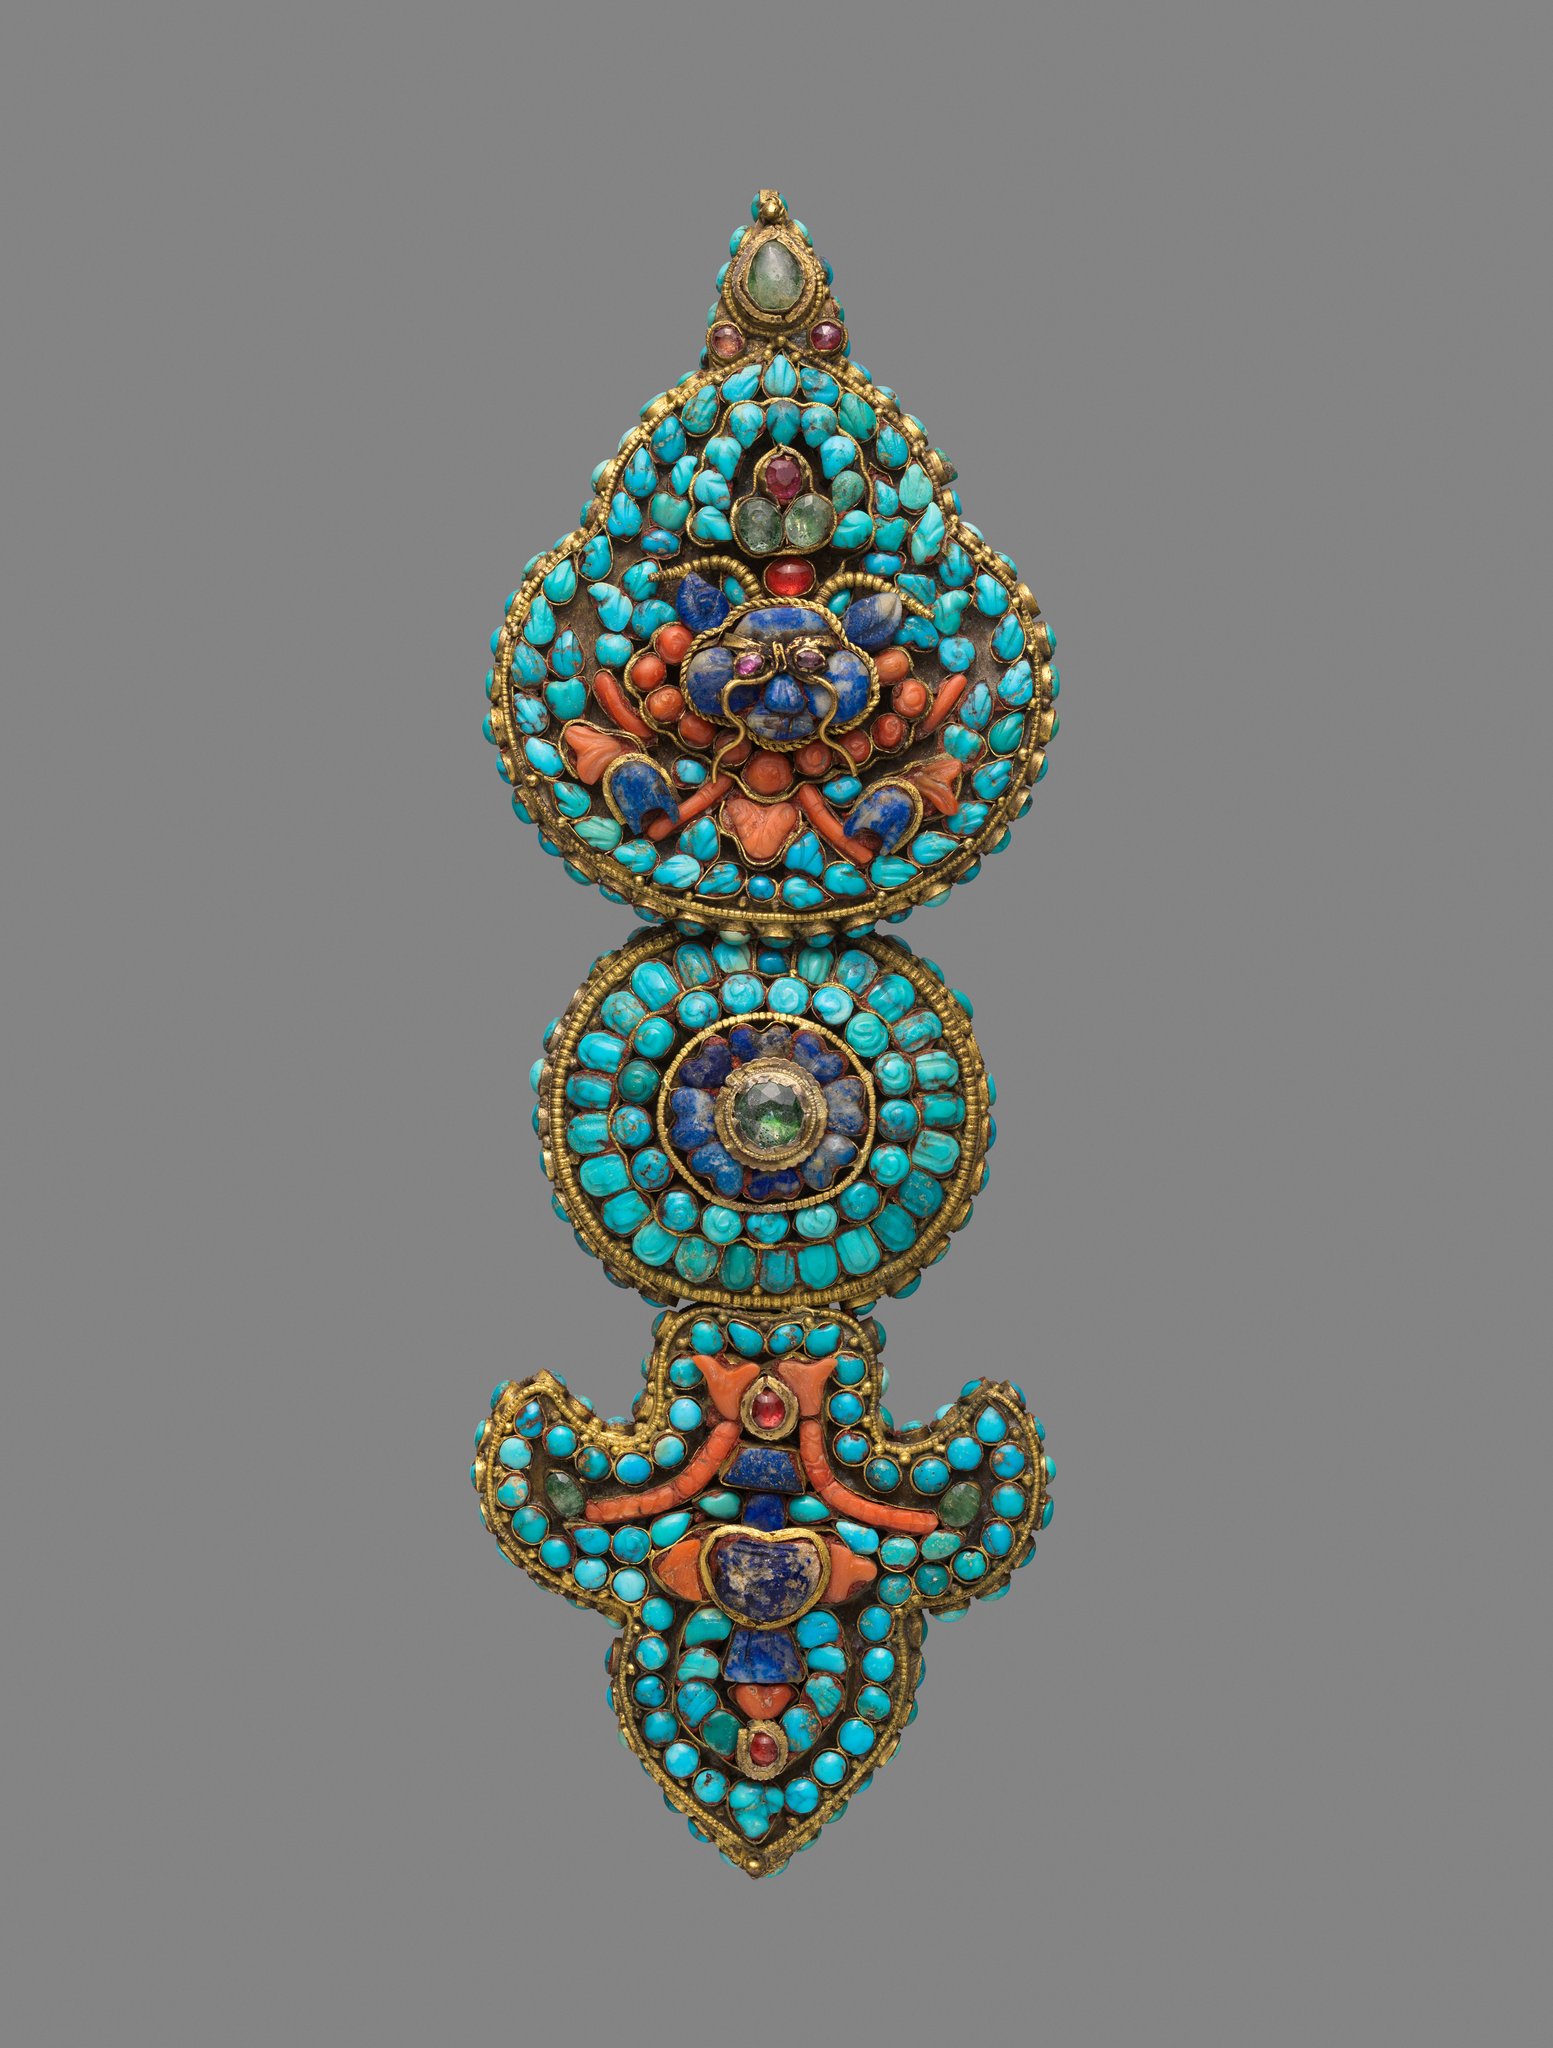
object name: ornament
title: Ear Ornament for a Deity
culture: nepali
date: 1601-1900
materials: coral, gold, shell